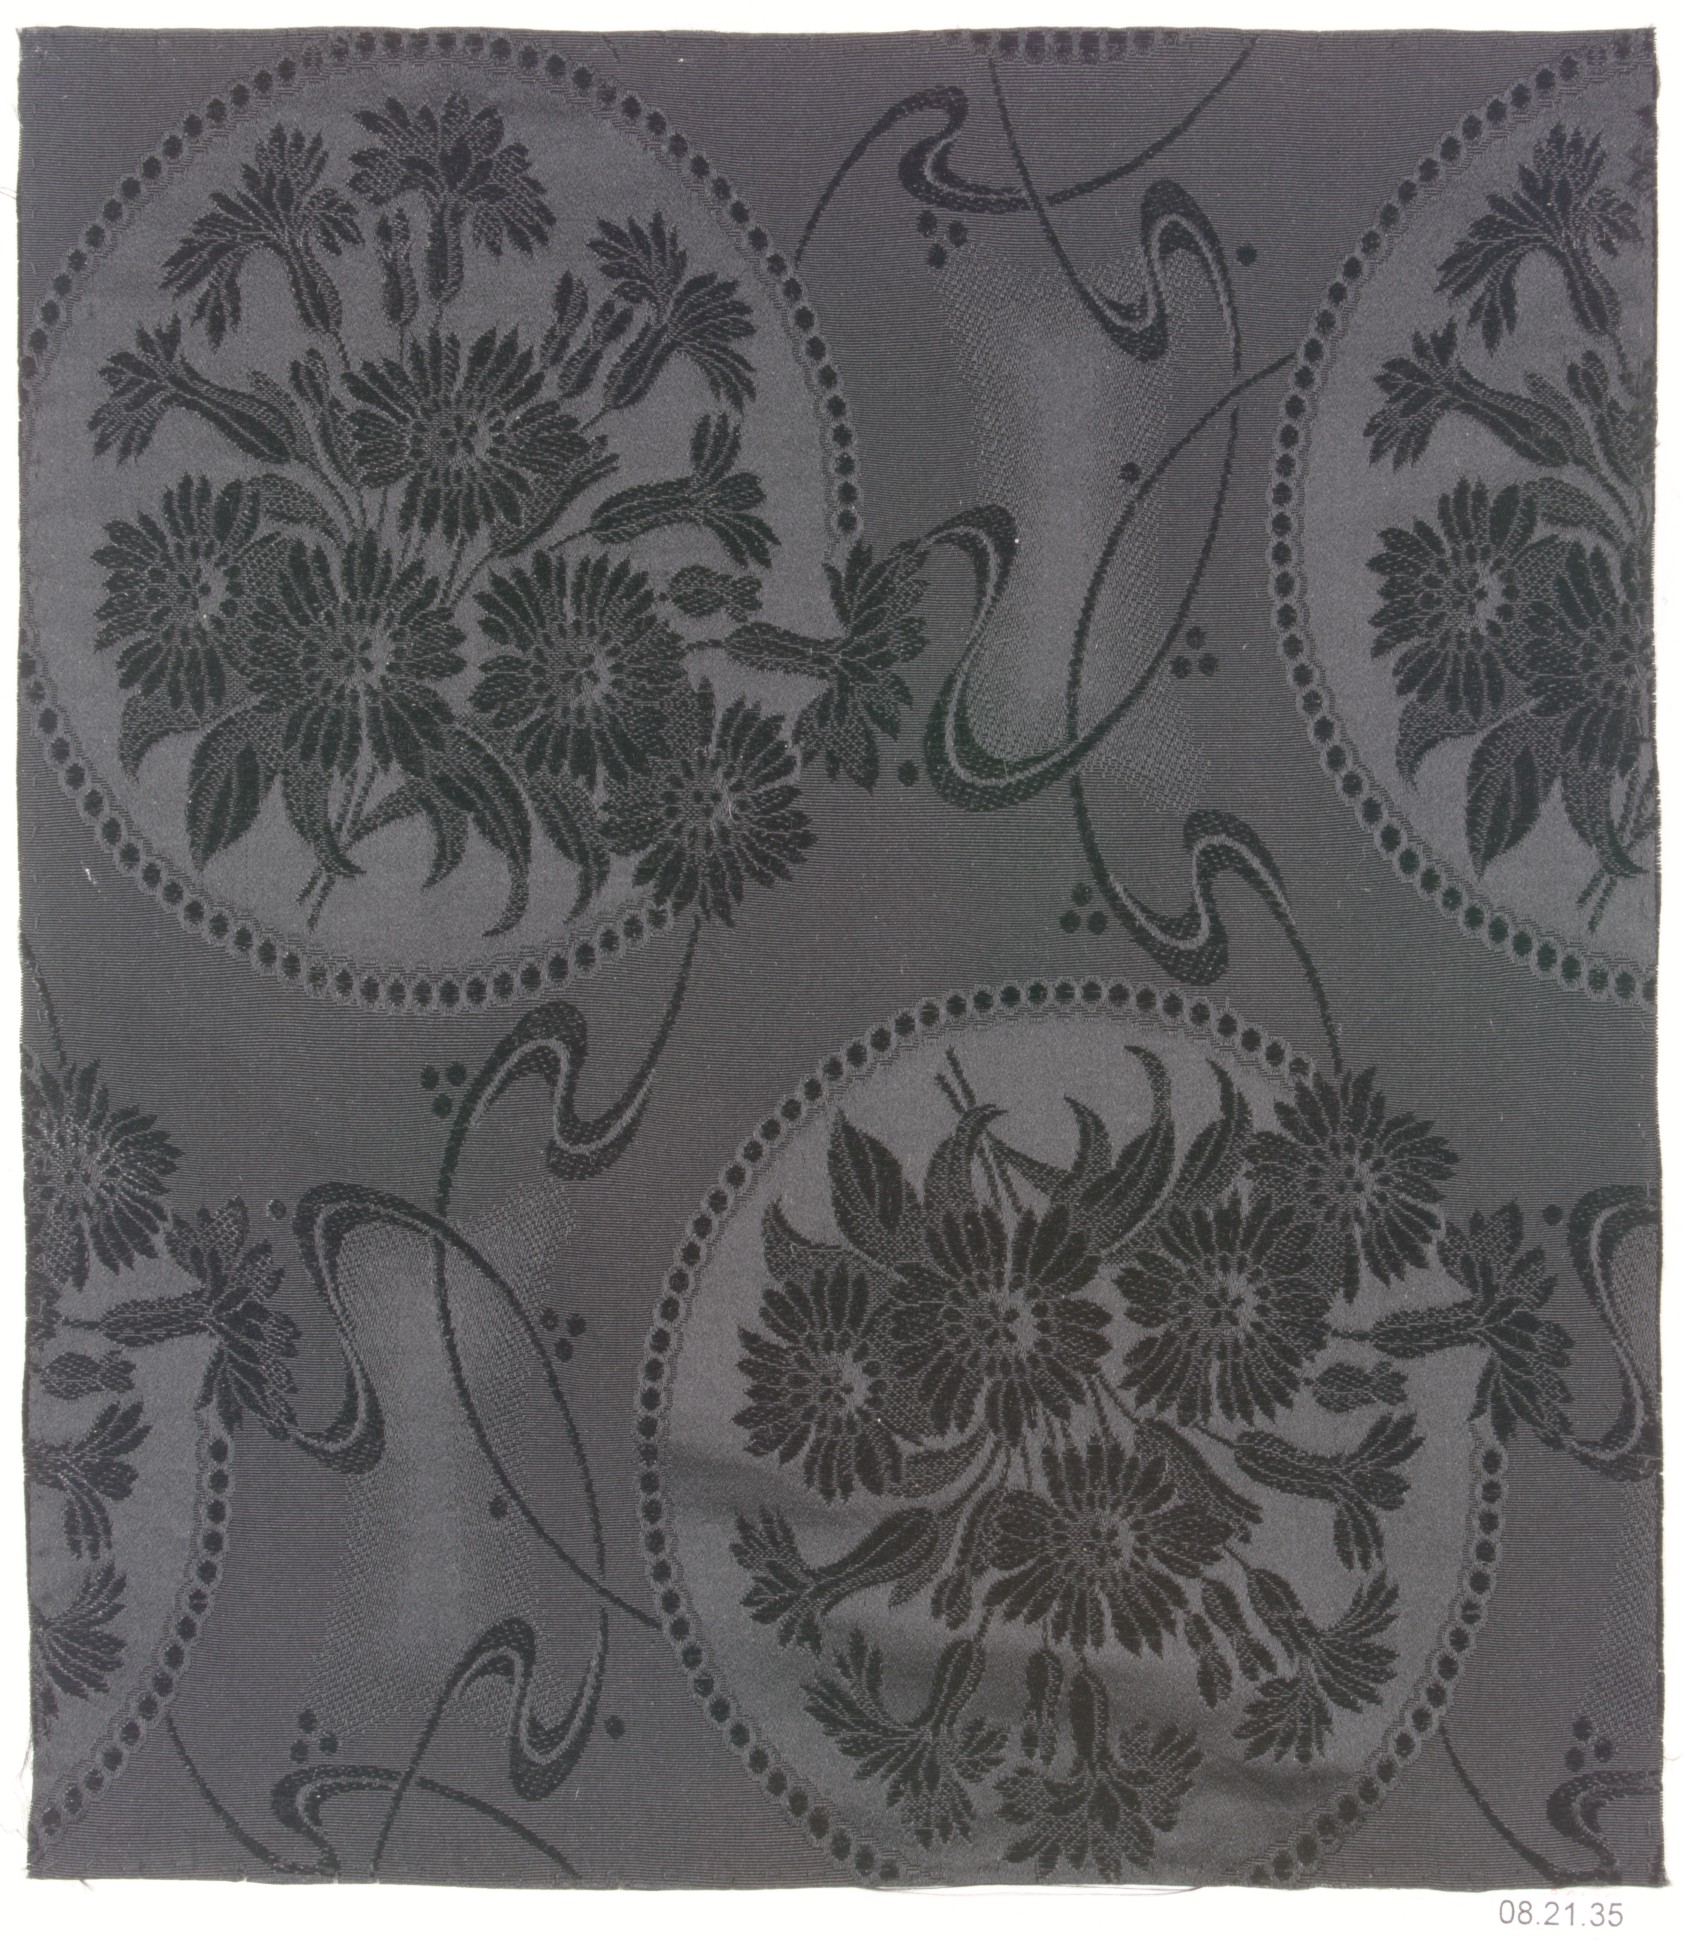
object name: textile sample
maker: Anonymous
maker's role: designer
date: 1900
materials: silk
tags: flowers